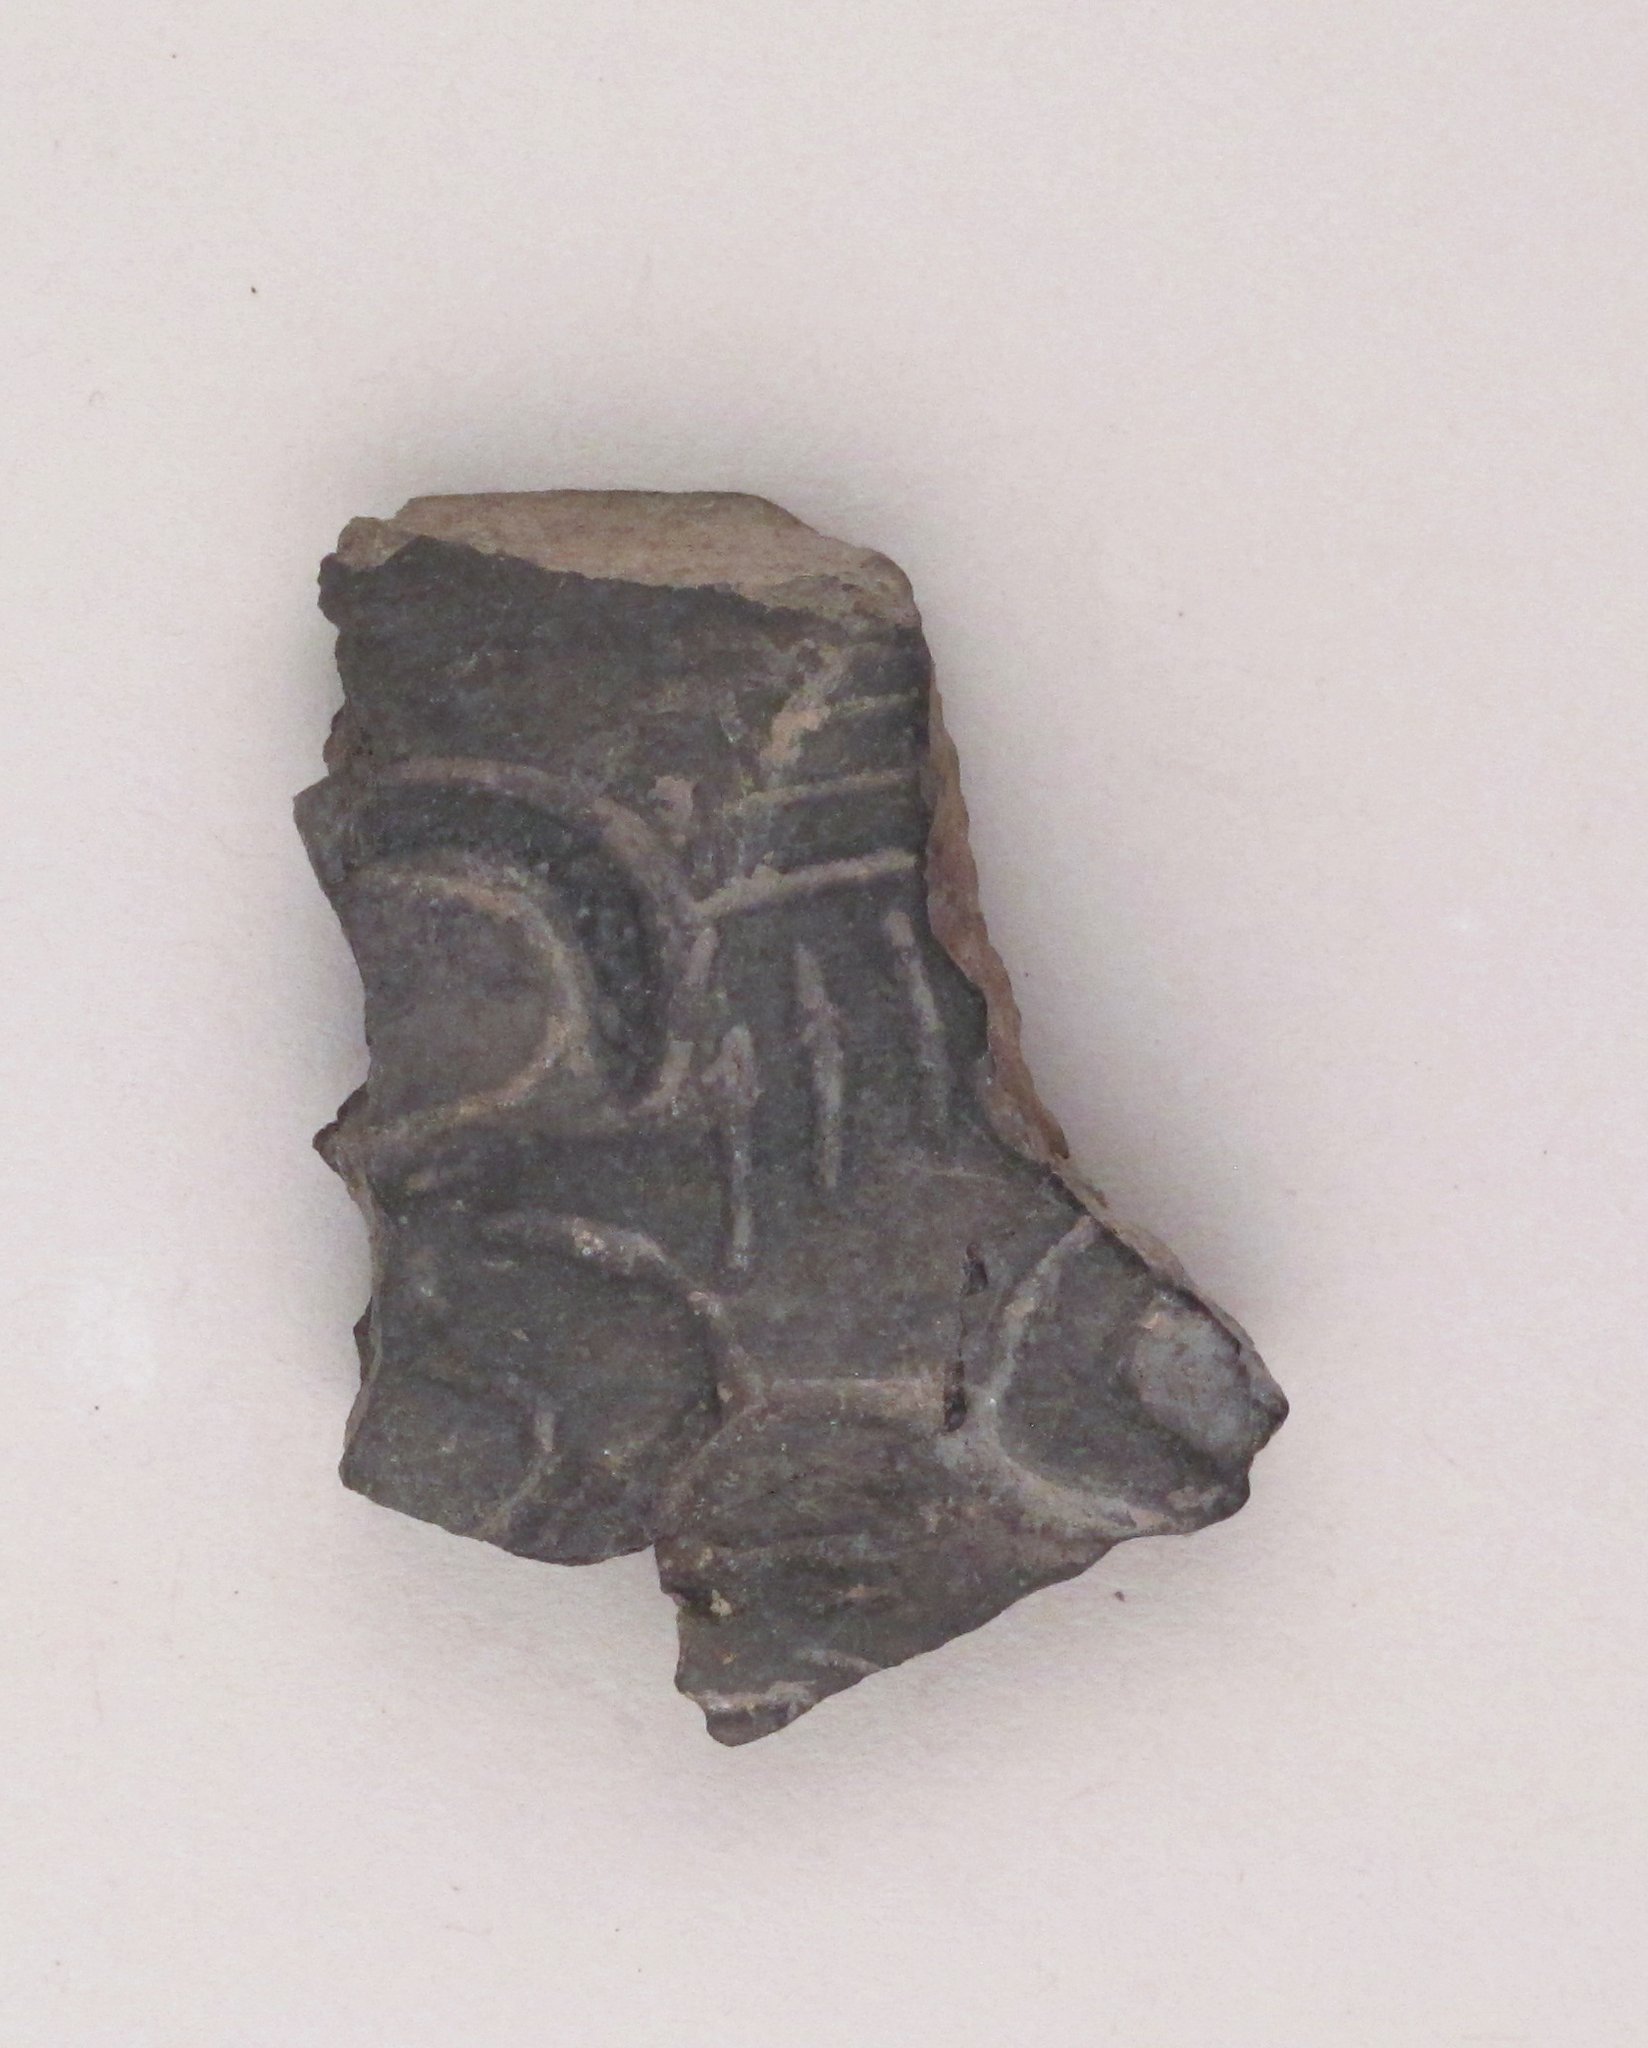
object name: vase fragment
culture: etruscan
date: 580-550 BCE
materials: terracotta